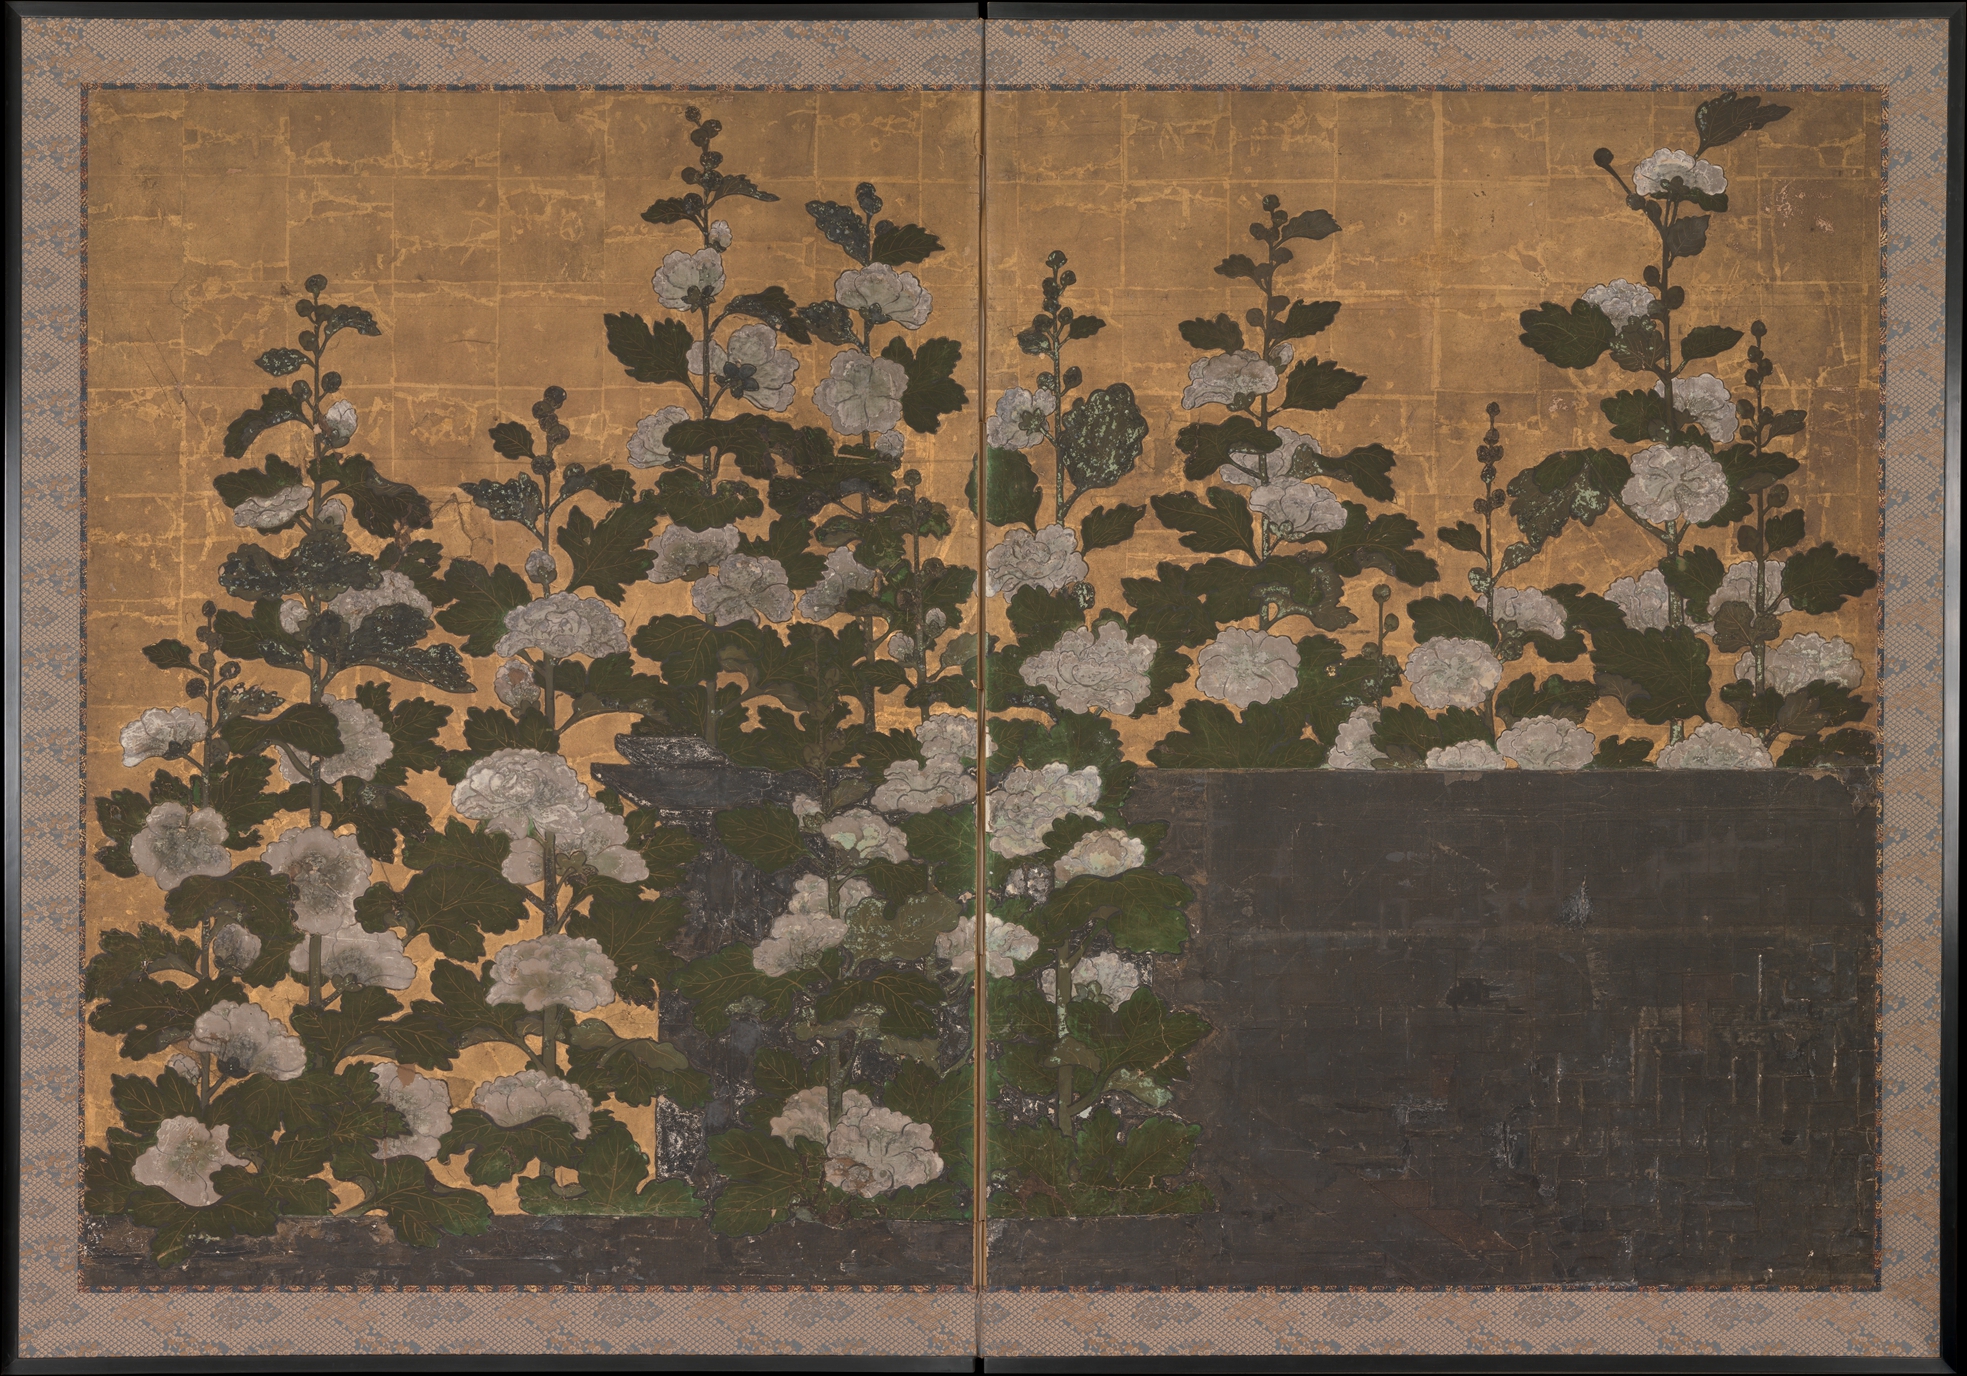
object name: screen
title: Hollyhocks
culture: japanese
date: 1601-1700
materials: gold, ink, panel, paper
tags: plants